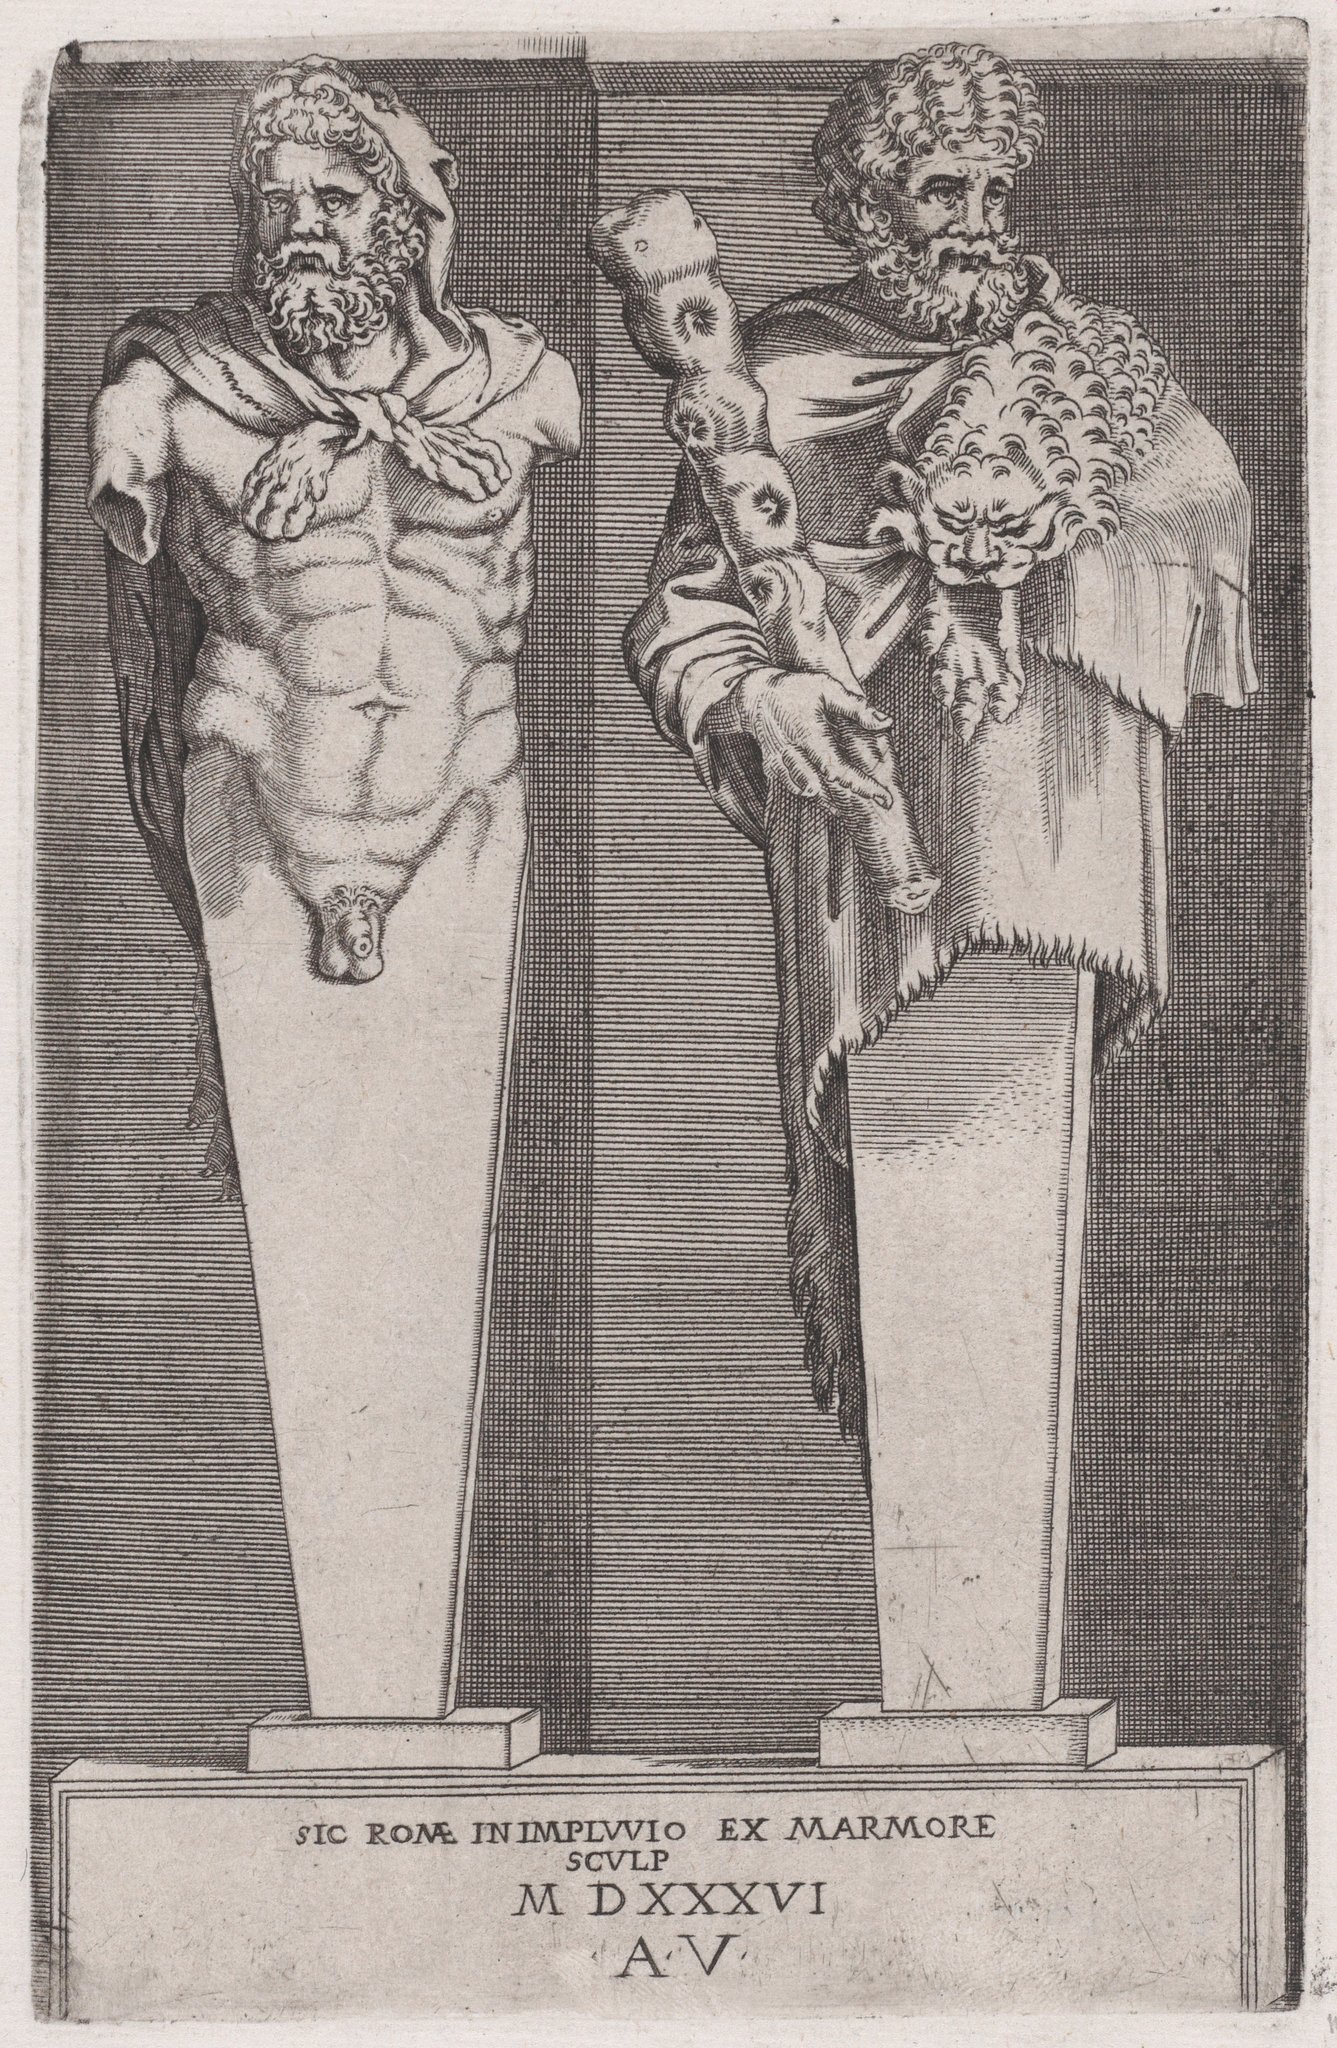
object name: print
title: Hercules, from "The Hermae"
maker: agostino veneziano (agostino dei musi)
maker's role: artist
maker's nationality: italian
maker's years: 1490-1536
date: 1536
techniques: engraving